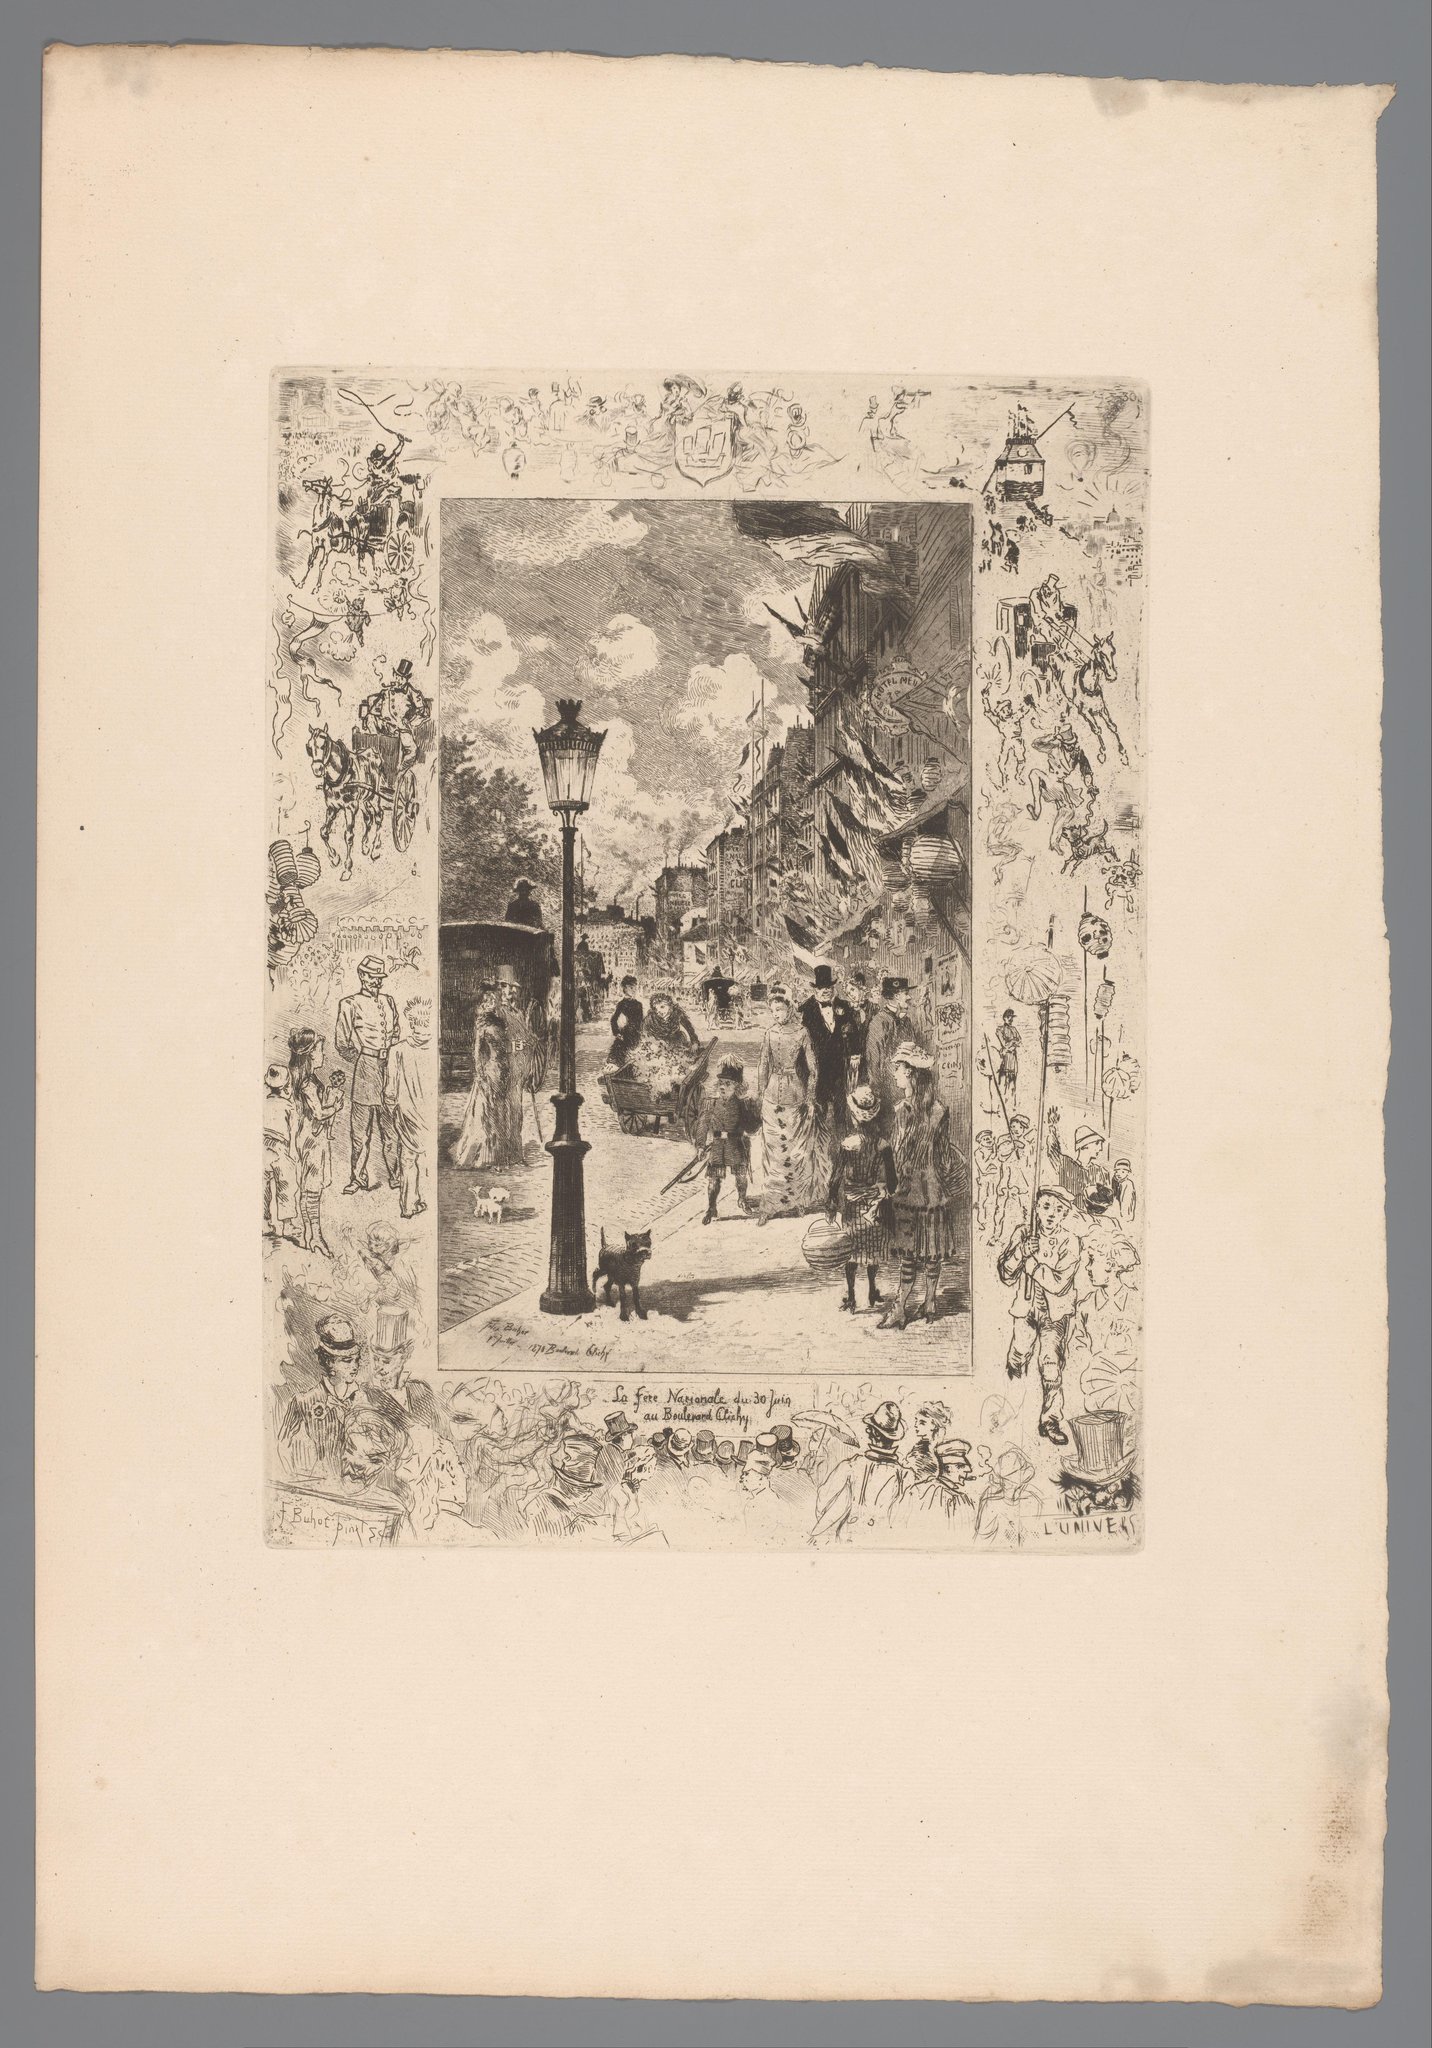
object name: print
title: Franse etsen uit 1879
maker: félix hilaire buhot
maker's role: draughtsman, print maker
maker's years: 1847-1898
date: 1879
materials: paper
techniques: aquatint, drypoint, etching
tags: festivities on events of national importance, avenue, boulevard, promenade, esplanade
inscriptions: collector's mark: ‘AFE v S’, watermark, collector's mark: Lugt 2760, collector's mark: Lugt 2228